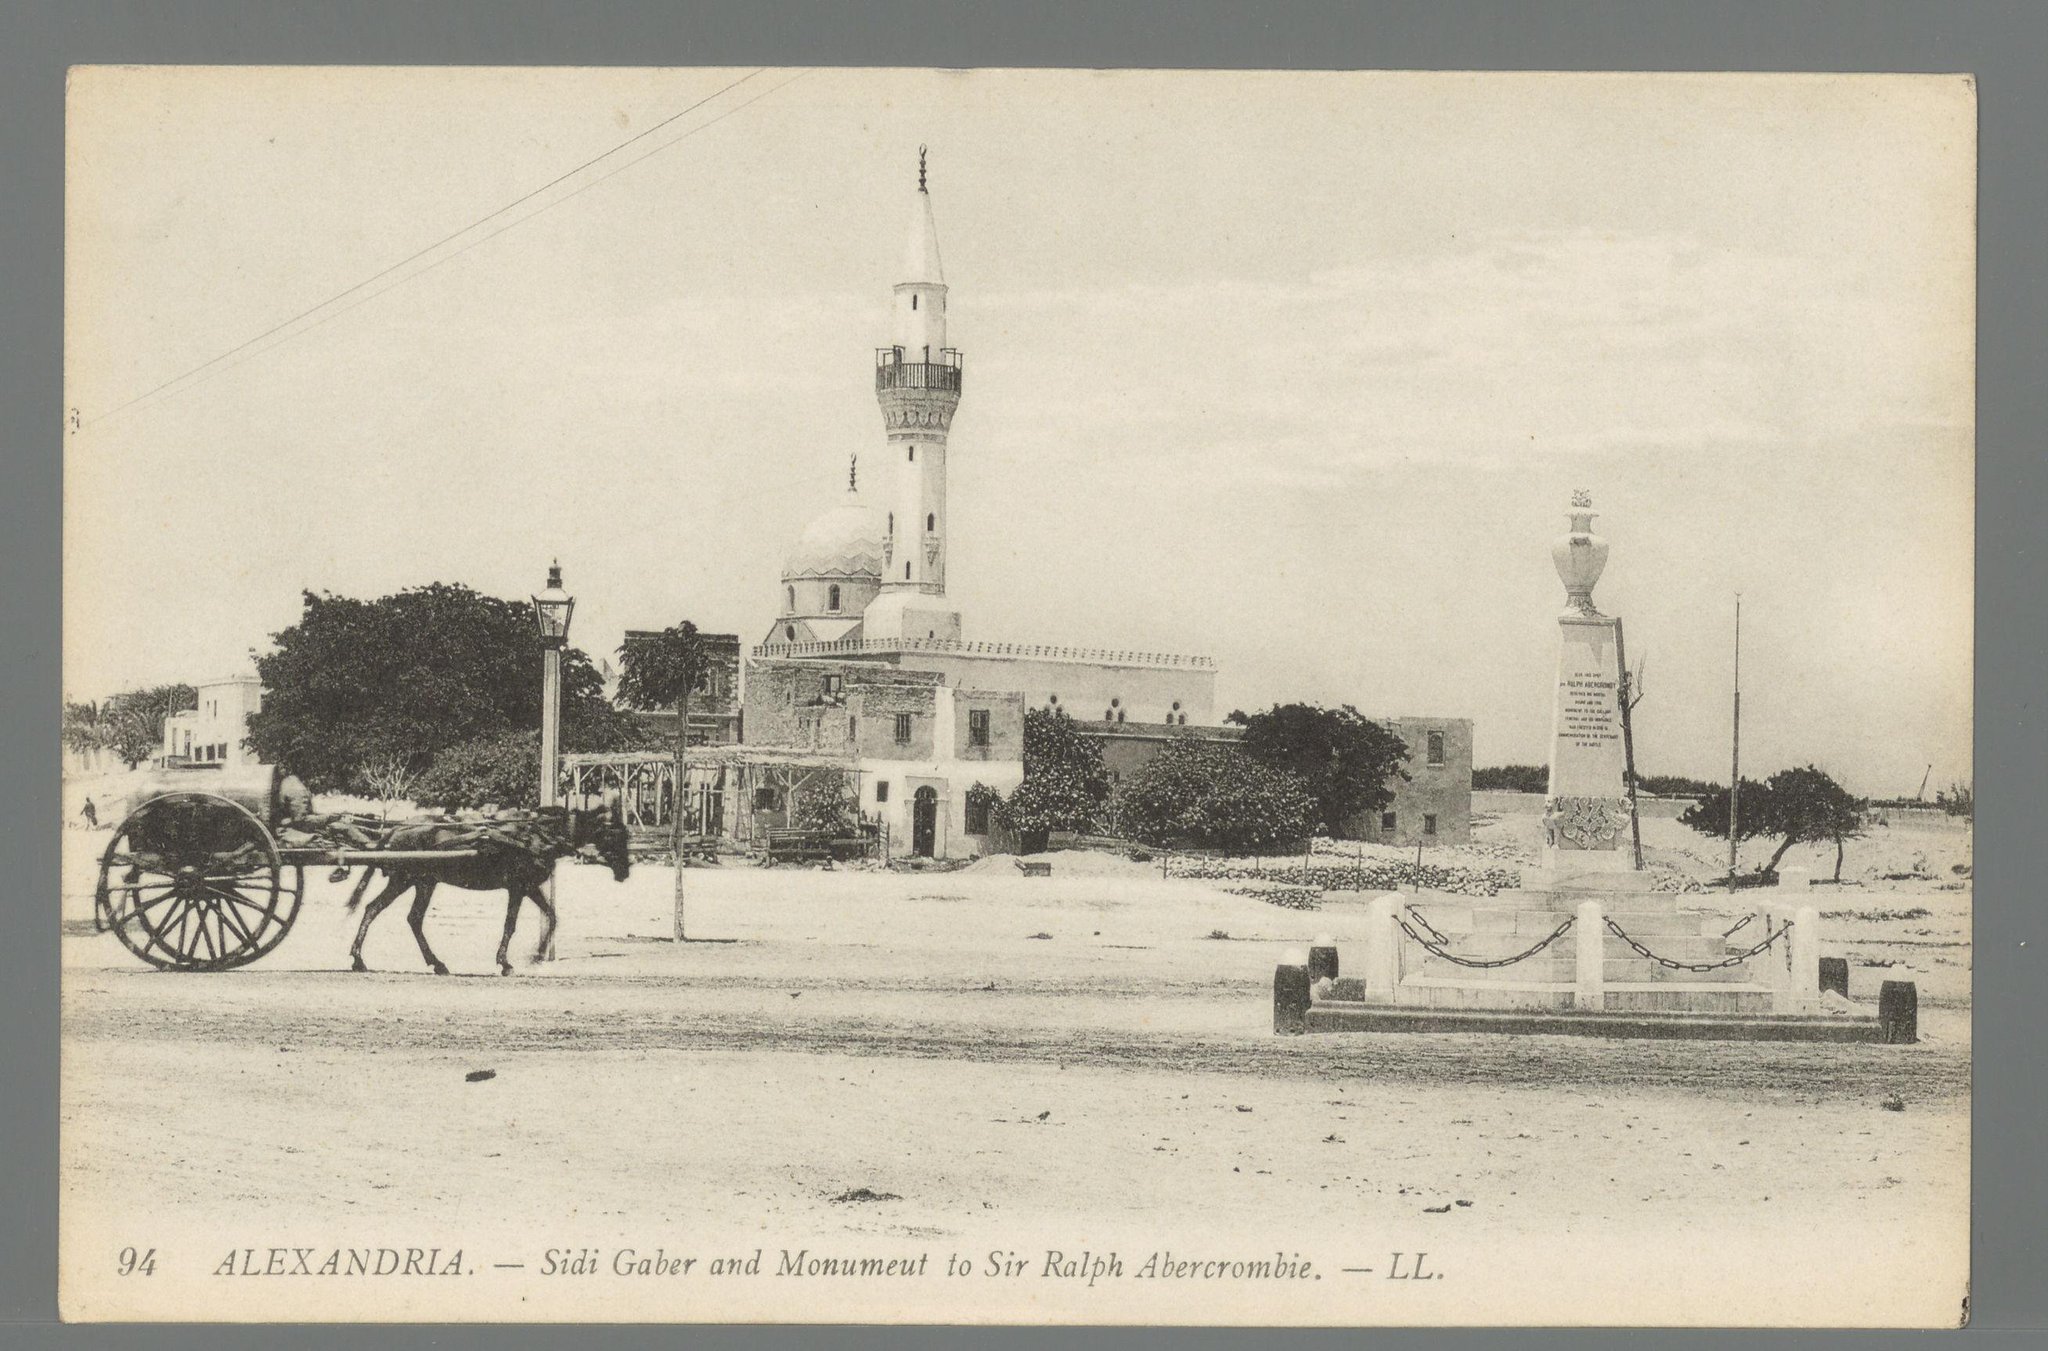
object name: photomechanical print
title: Alexandria - Sidi Gaber and Monument to Sir Ralph Abercrombie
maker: Anonymous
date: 1907-1930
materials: cardboard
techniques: photograph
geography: paris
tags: ralph abercromby, monument, statue, temple, shrine ~ islam, mohammedanism